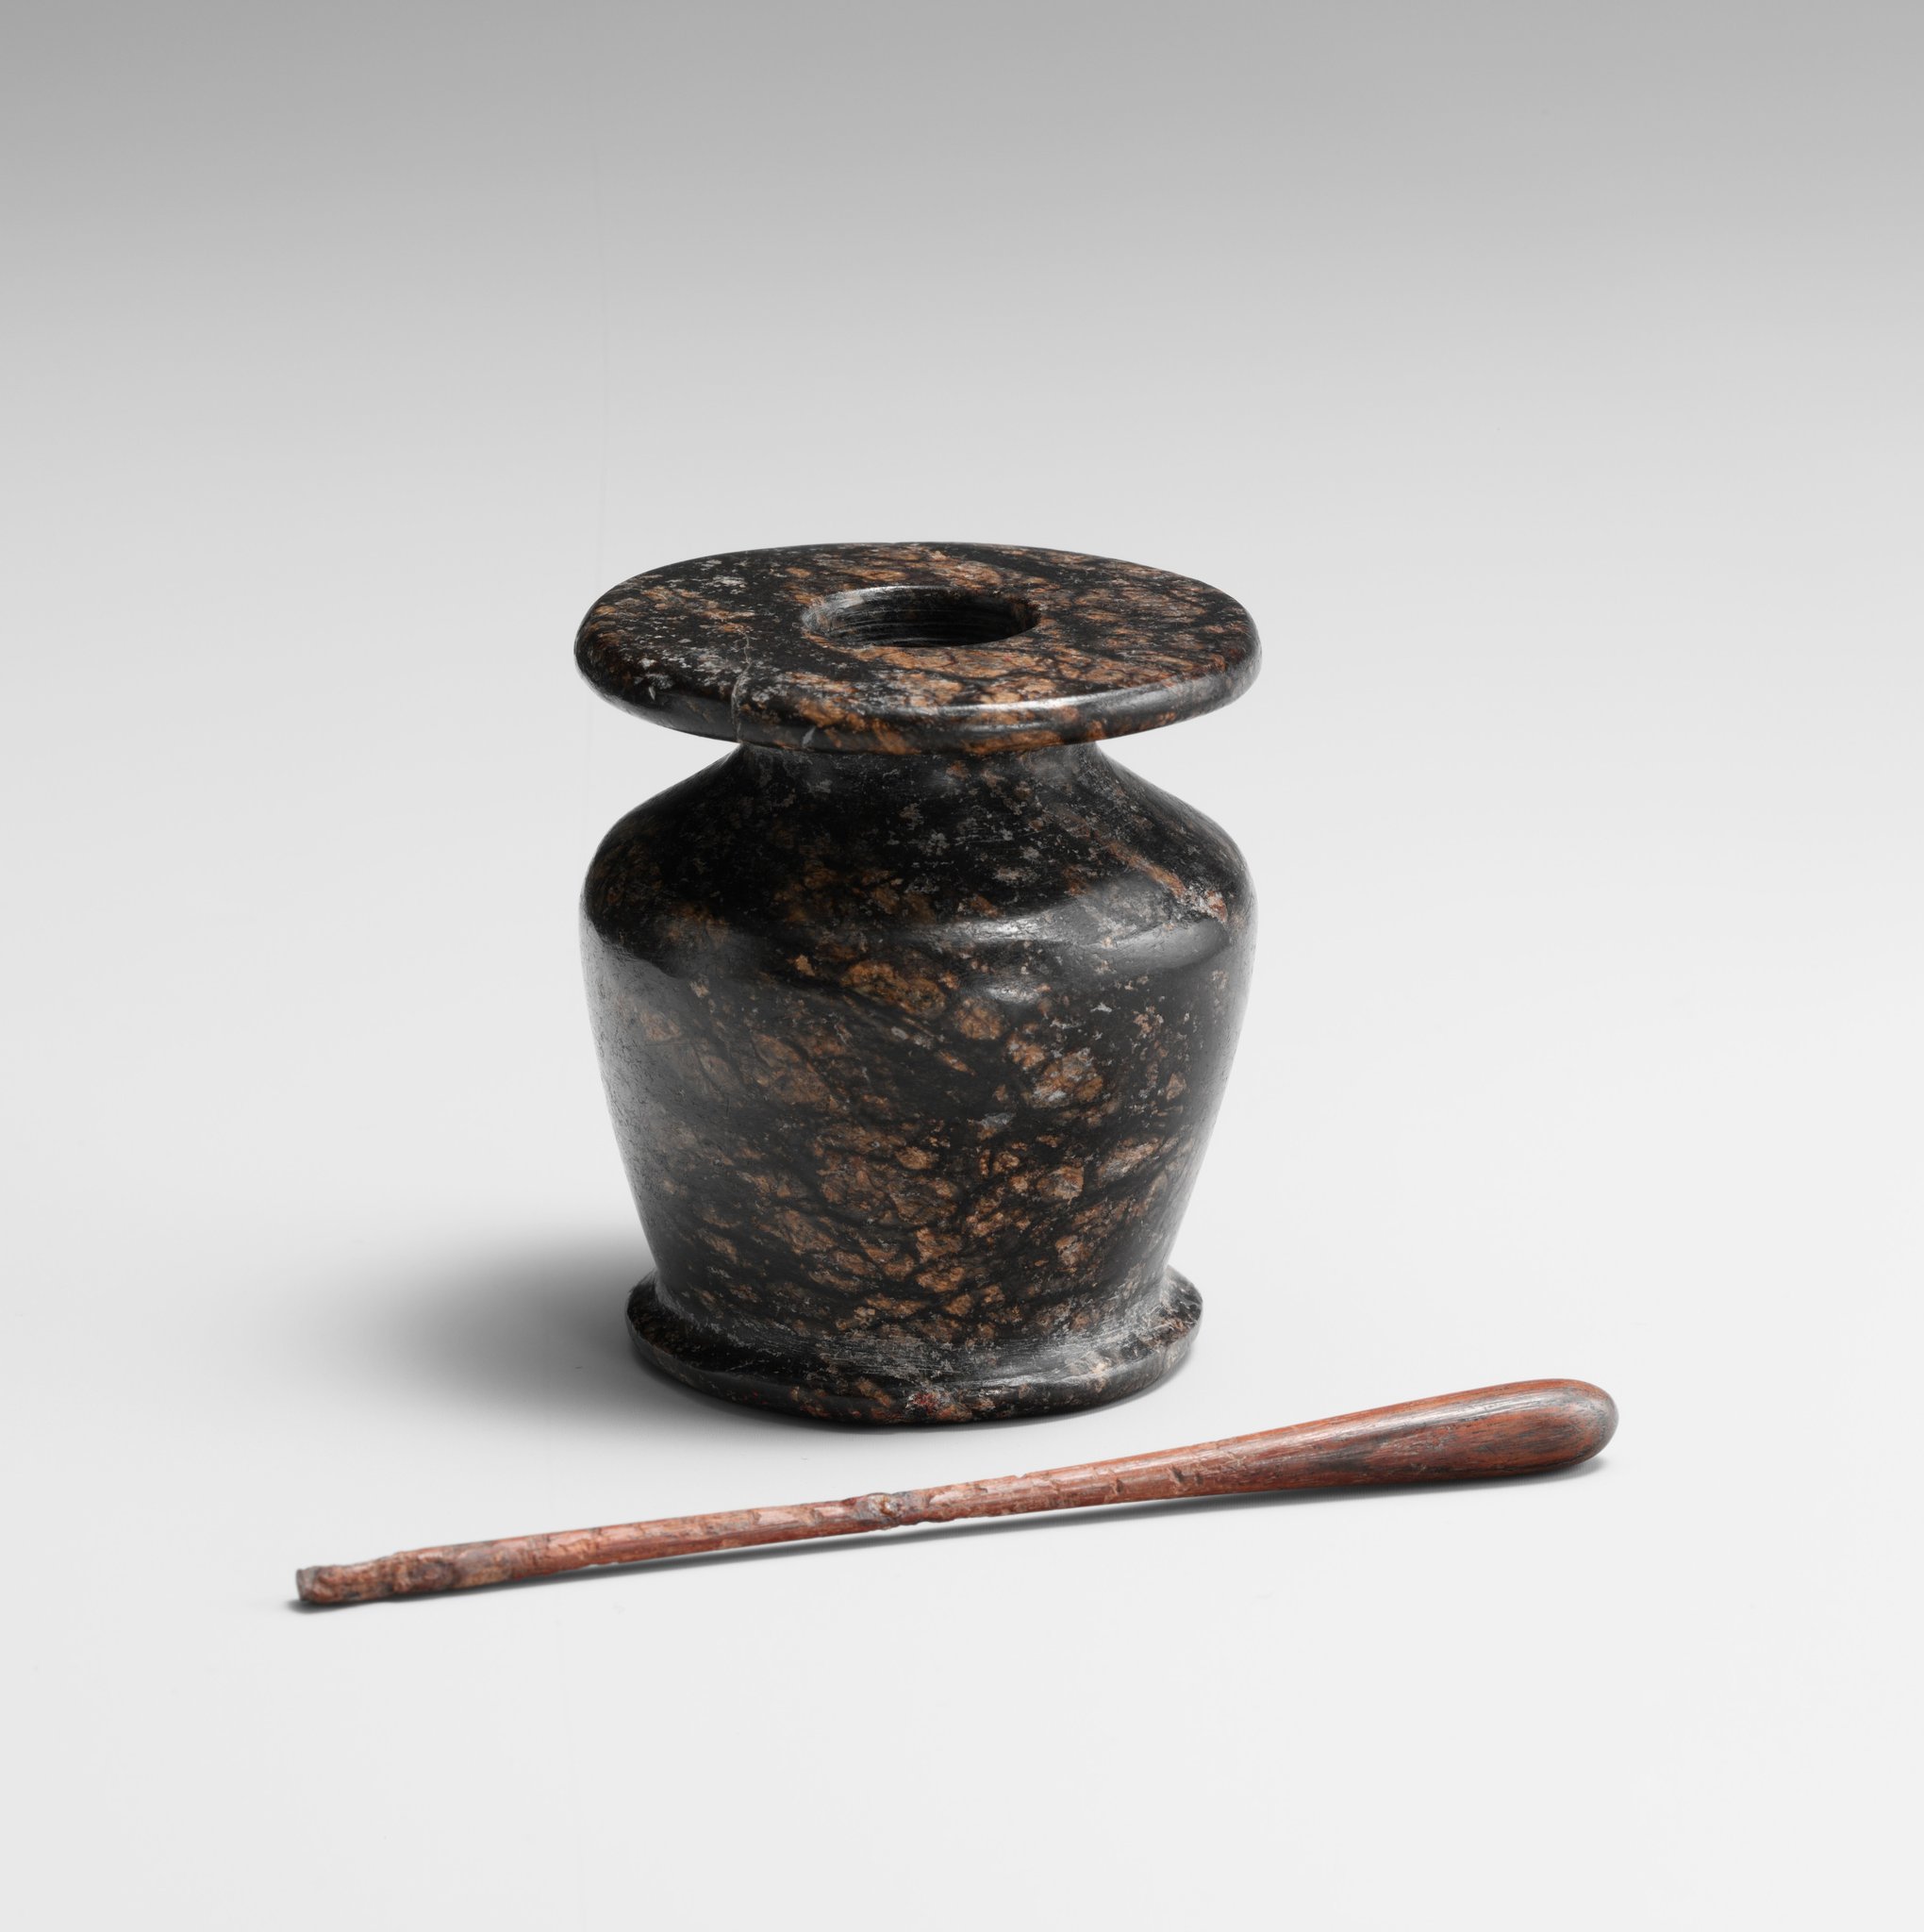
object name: kohl jar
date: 1492-1473 BCE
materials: stone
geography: egypt